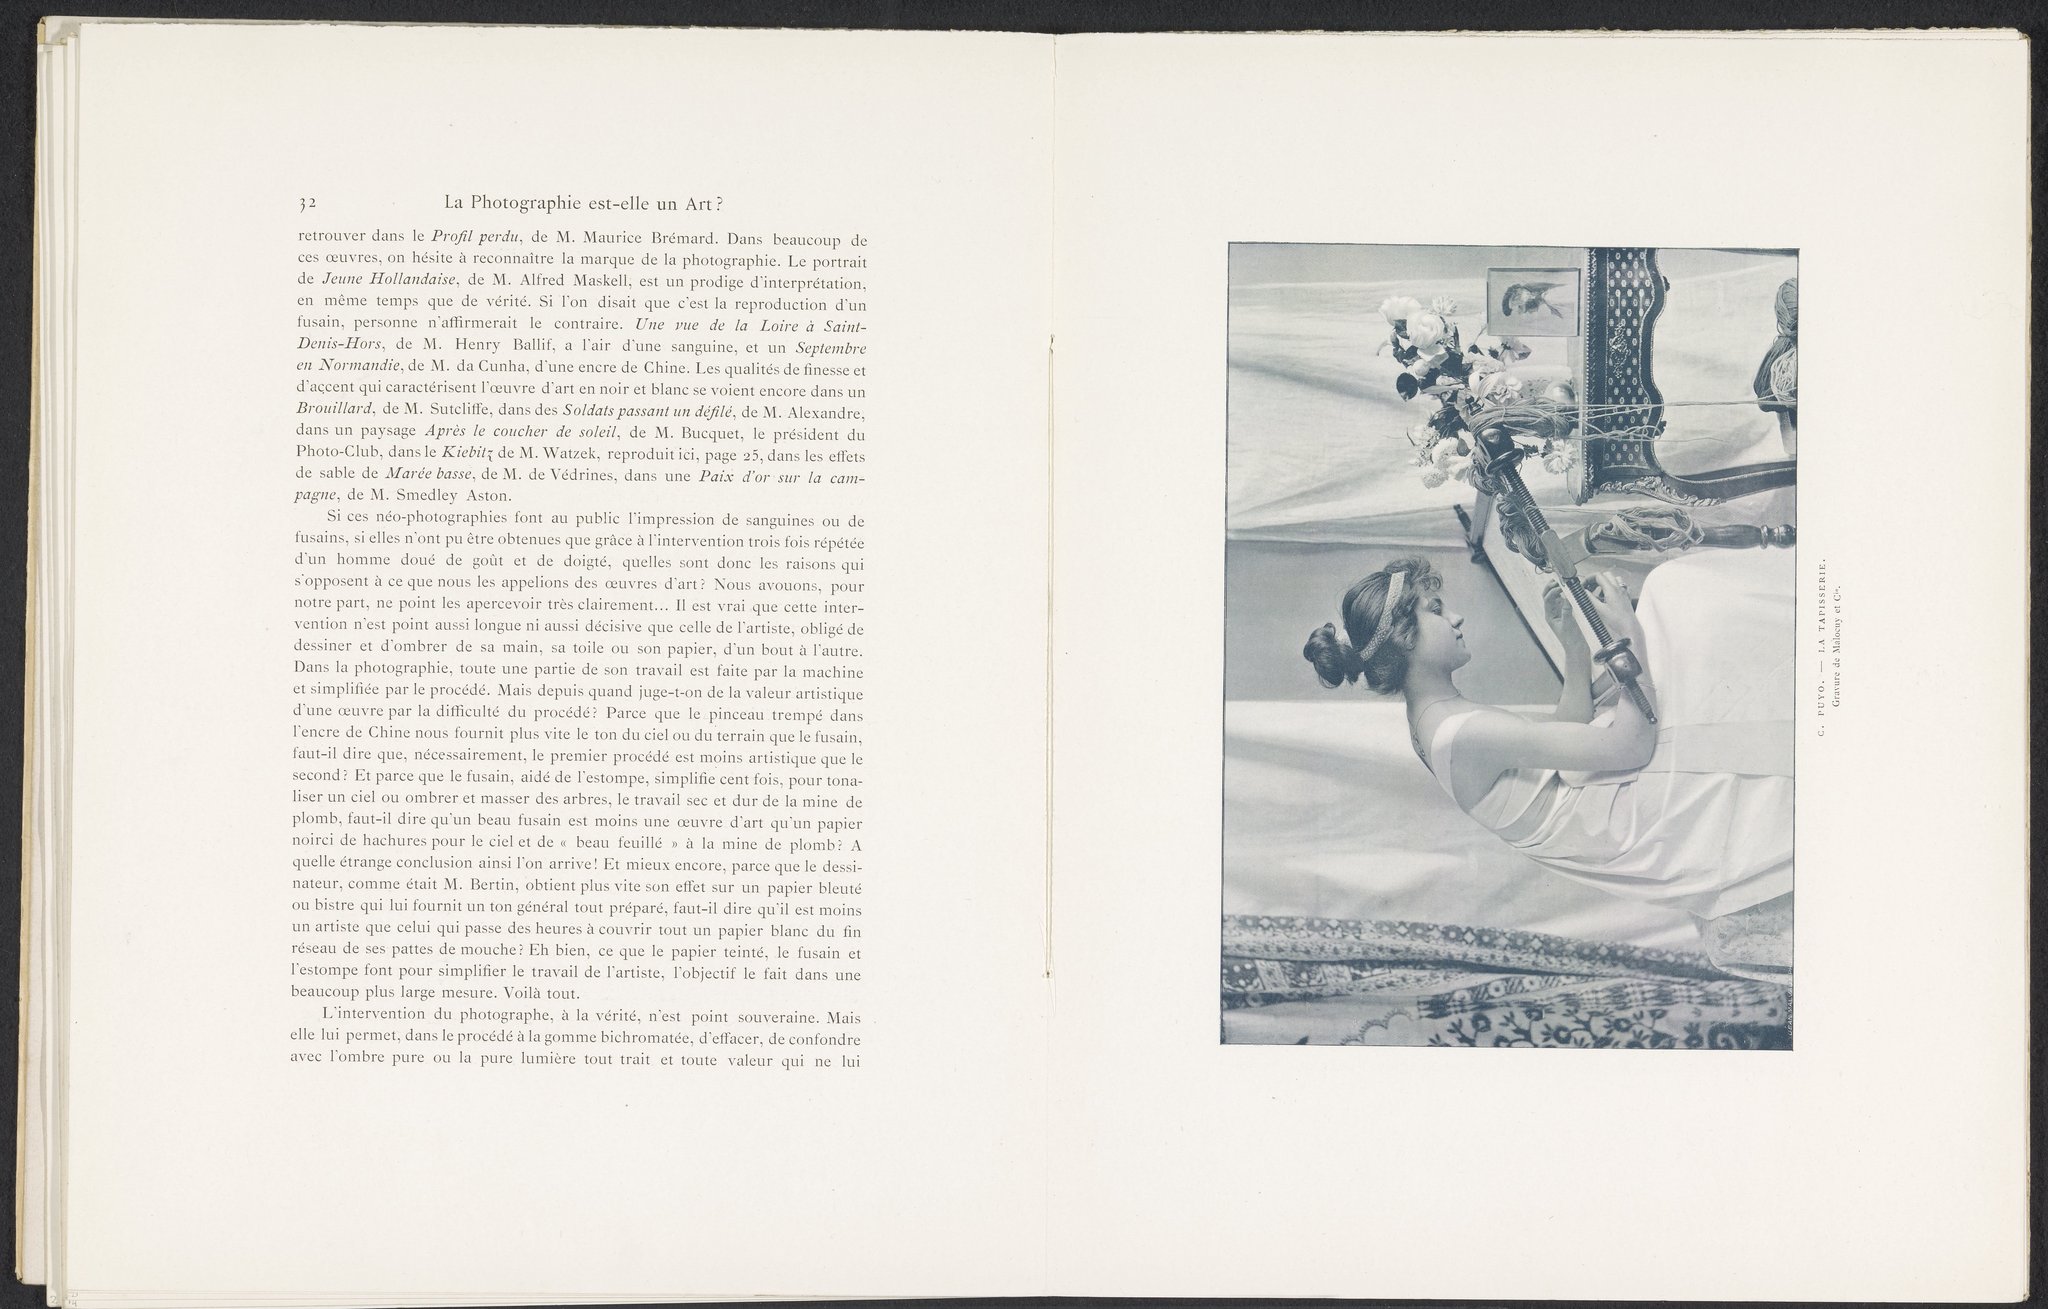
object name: photomechanical print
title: La tapisserie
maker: constant puyo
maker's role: fotograaf, schrijver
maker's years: 1857-1933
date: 1889-1899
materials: paper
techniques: autotype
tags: weaving-loom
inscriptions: name: ‘Jean Malvaux PH’